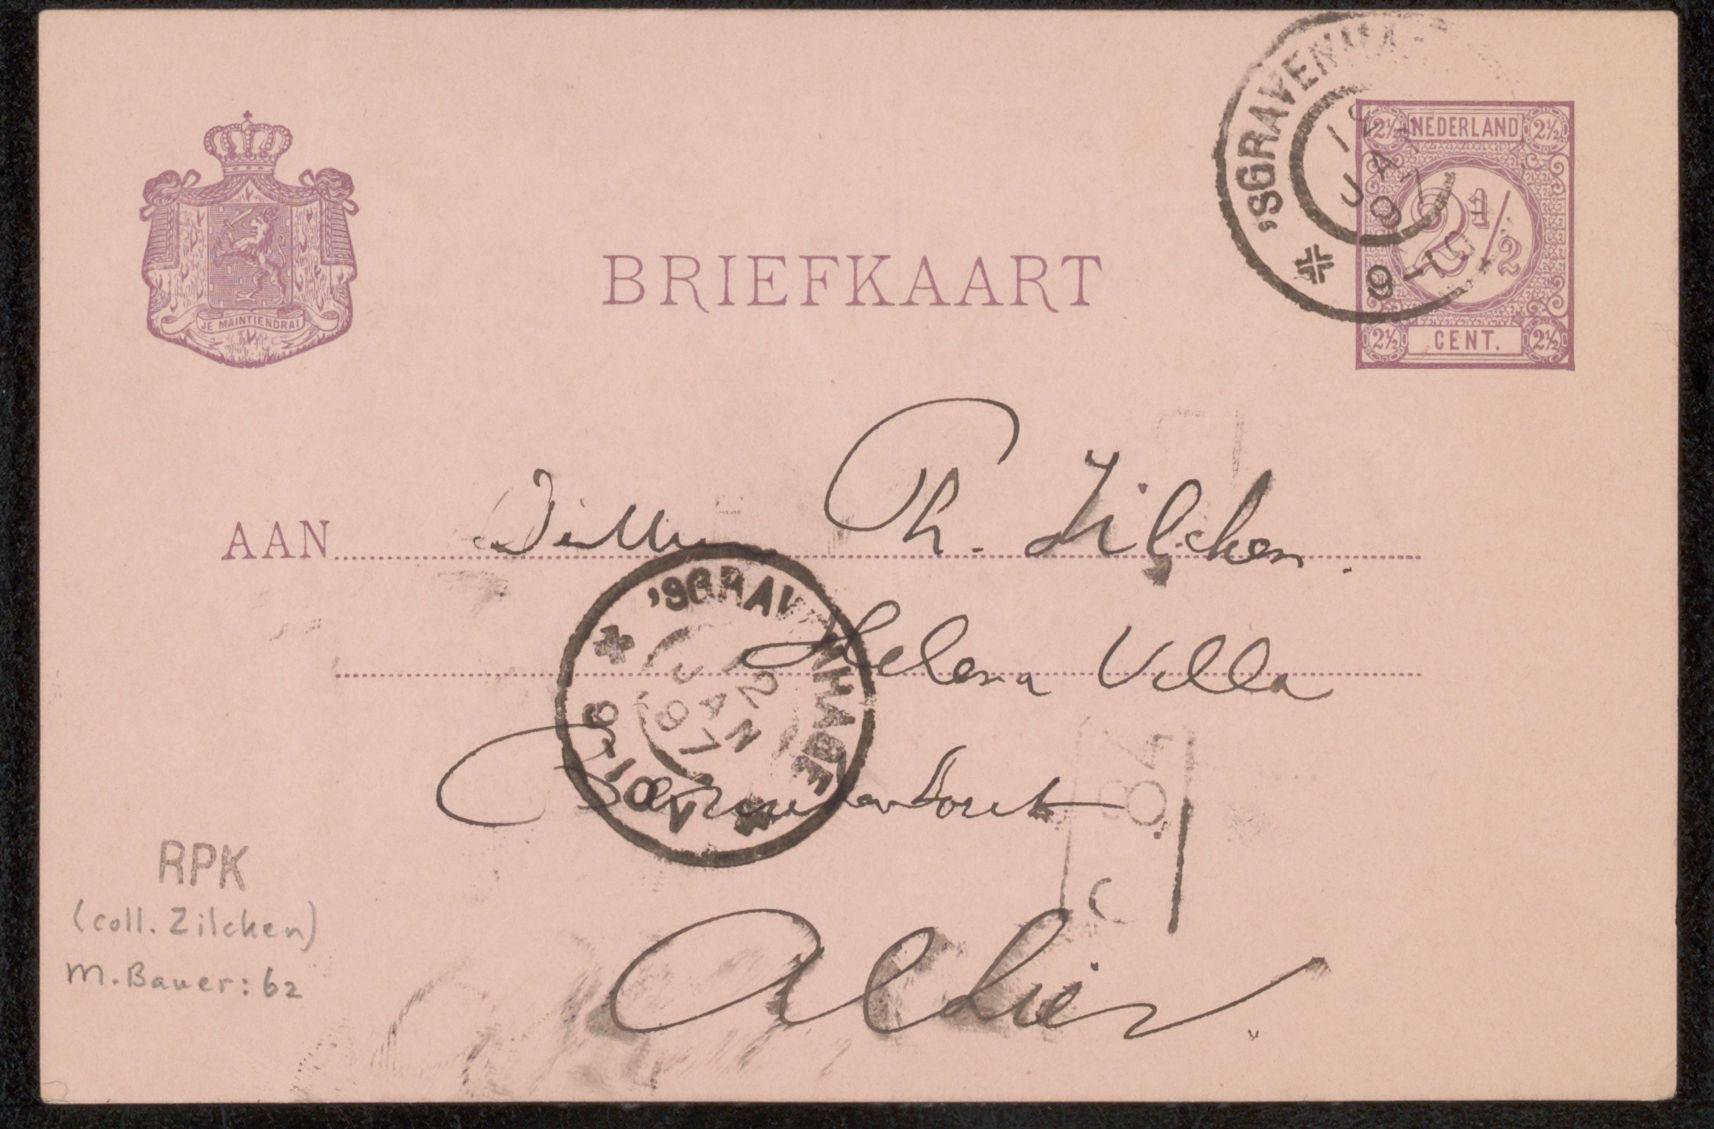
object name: postcard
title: Briefkaart aan Philip Zilcken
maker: marius bauer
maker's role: draughtsman, print maker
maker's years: 1867-1932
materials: cardboard, ink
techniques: pen, writing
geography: the hague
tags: painter, draughtsman, philip zilcken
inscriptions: collector's mark: ‘RPK’